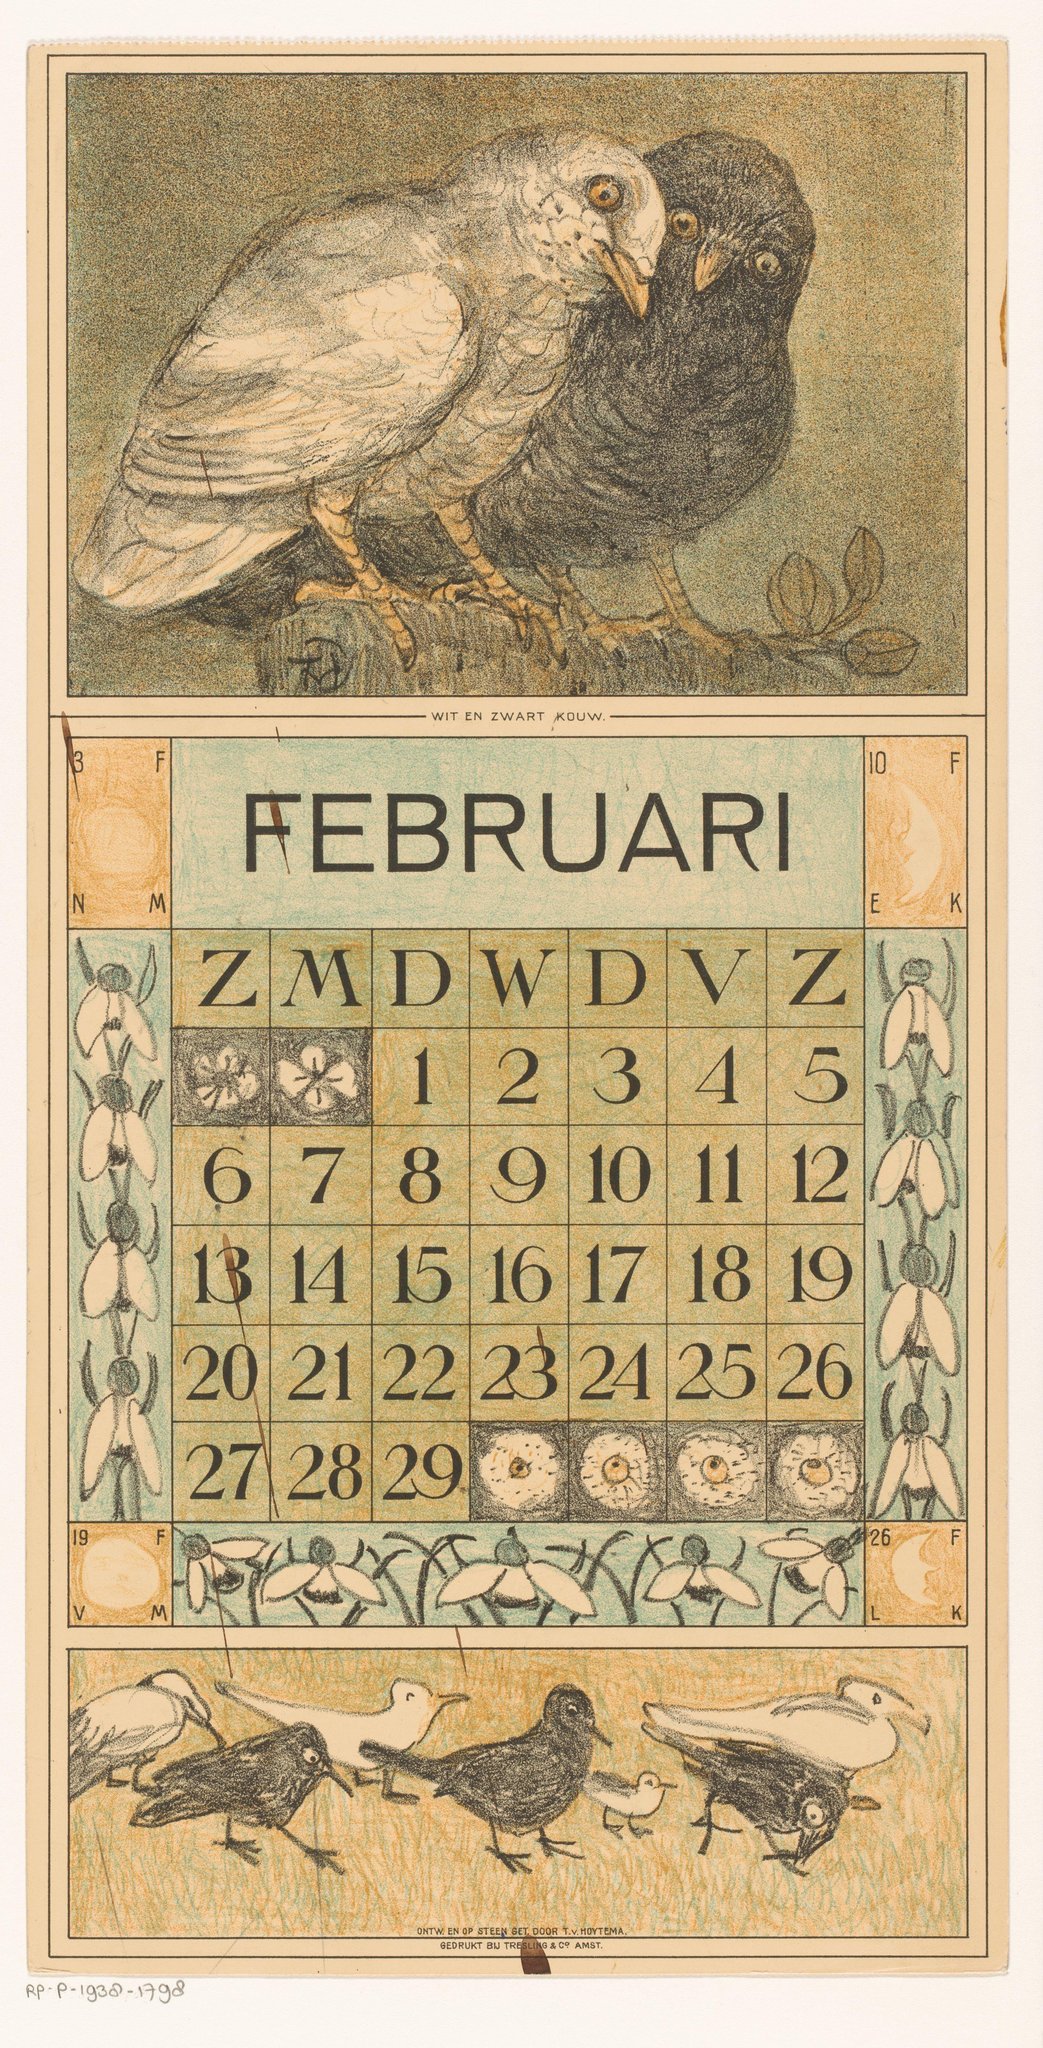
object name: print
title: Kalender 1916 12 lithografien door Th. v. Hoytema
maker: theo van hoytema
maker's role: draughtsman, painter, print maker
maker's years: 1863-1917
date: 1915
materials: paper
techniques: lithograph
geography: amsterdam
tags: song-birds: jackdaw, lunar year, shore-birds and wading-birds: gull, february ~ other concepts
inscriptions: collector's mark: Lugt 2228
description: In het calendarium en de ornamentrand bloemen. Onderin kauwen en meeuwen. In de hoeken de standen van de maan op vier dagen. Bovenaan het blad een scheurlijn.